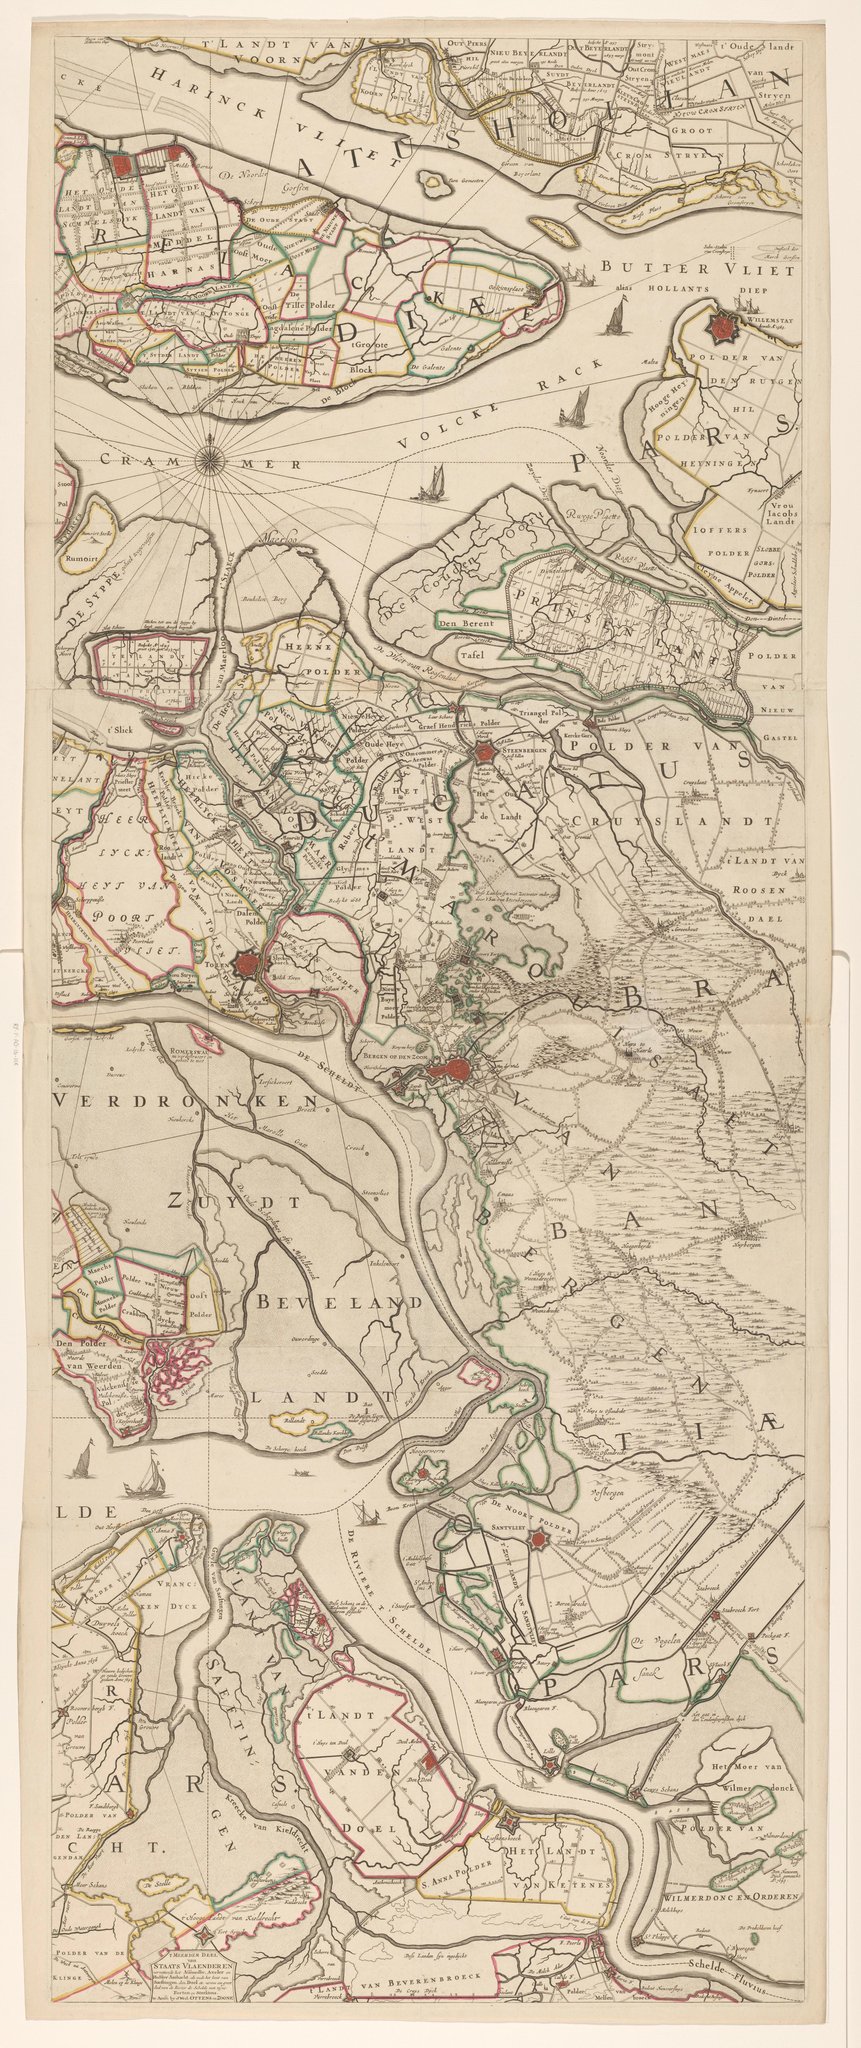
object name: map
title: t Meerder deel van Staats Vlaenderen vervattende het Asseneder, Axeler en Hulster Ambacht, als mede het lant van Saeftingen, den Doel etc. nevens een groot deel van de Rivier de Schelde met zyne Forten en Sterktens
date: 1655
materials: paper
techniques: engraving, etching, hand coloring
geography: amsterdam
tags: maps of separate countries or regions, zeeland, brabant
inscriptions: collector's mark: Lugt 19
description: De drie bladen van deze kaart komen ook voor als onderdeel van de zogenaamde Visscher-Romankaart, een wandkaart van Zeeland. Zie RP-P-AO-15-13, RP-P-AO-15-13B en documentatie voor meer informatie. De samenstelling van deze drie bladen is niet bedoeld als een los uit te geven kaart van een bepaald gebied, zoals wel het geval is bij bijvoorbeeld RP-P-AO-16-11. Deze drie bladen samen vormen in feite het rechterdeel van de Visscher-Romankaart.